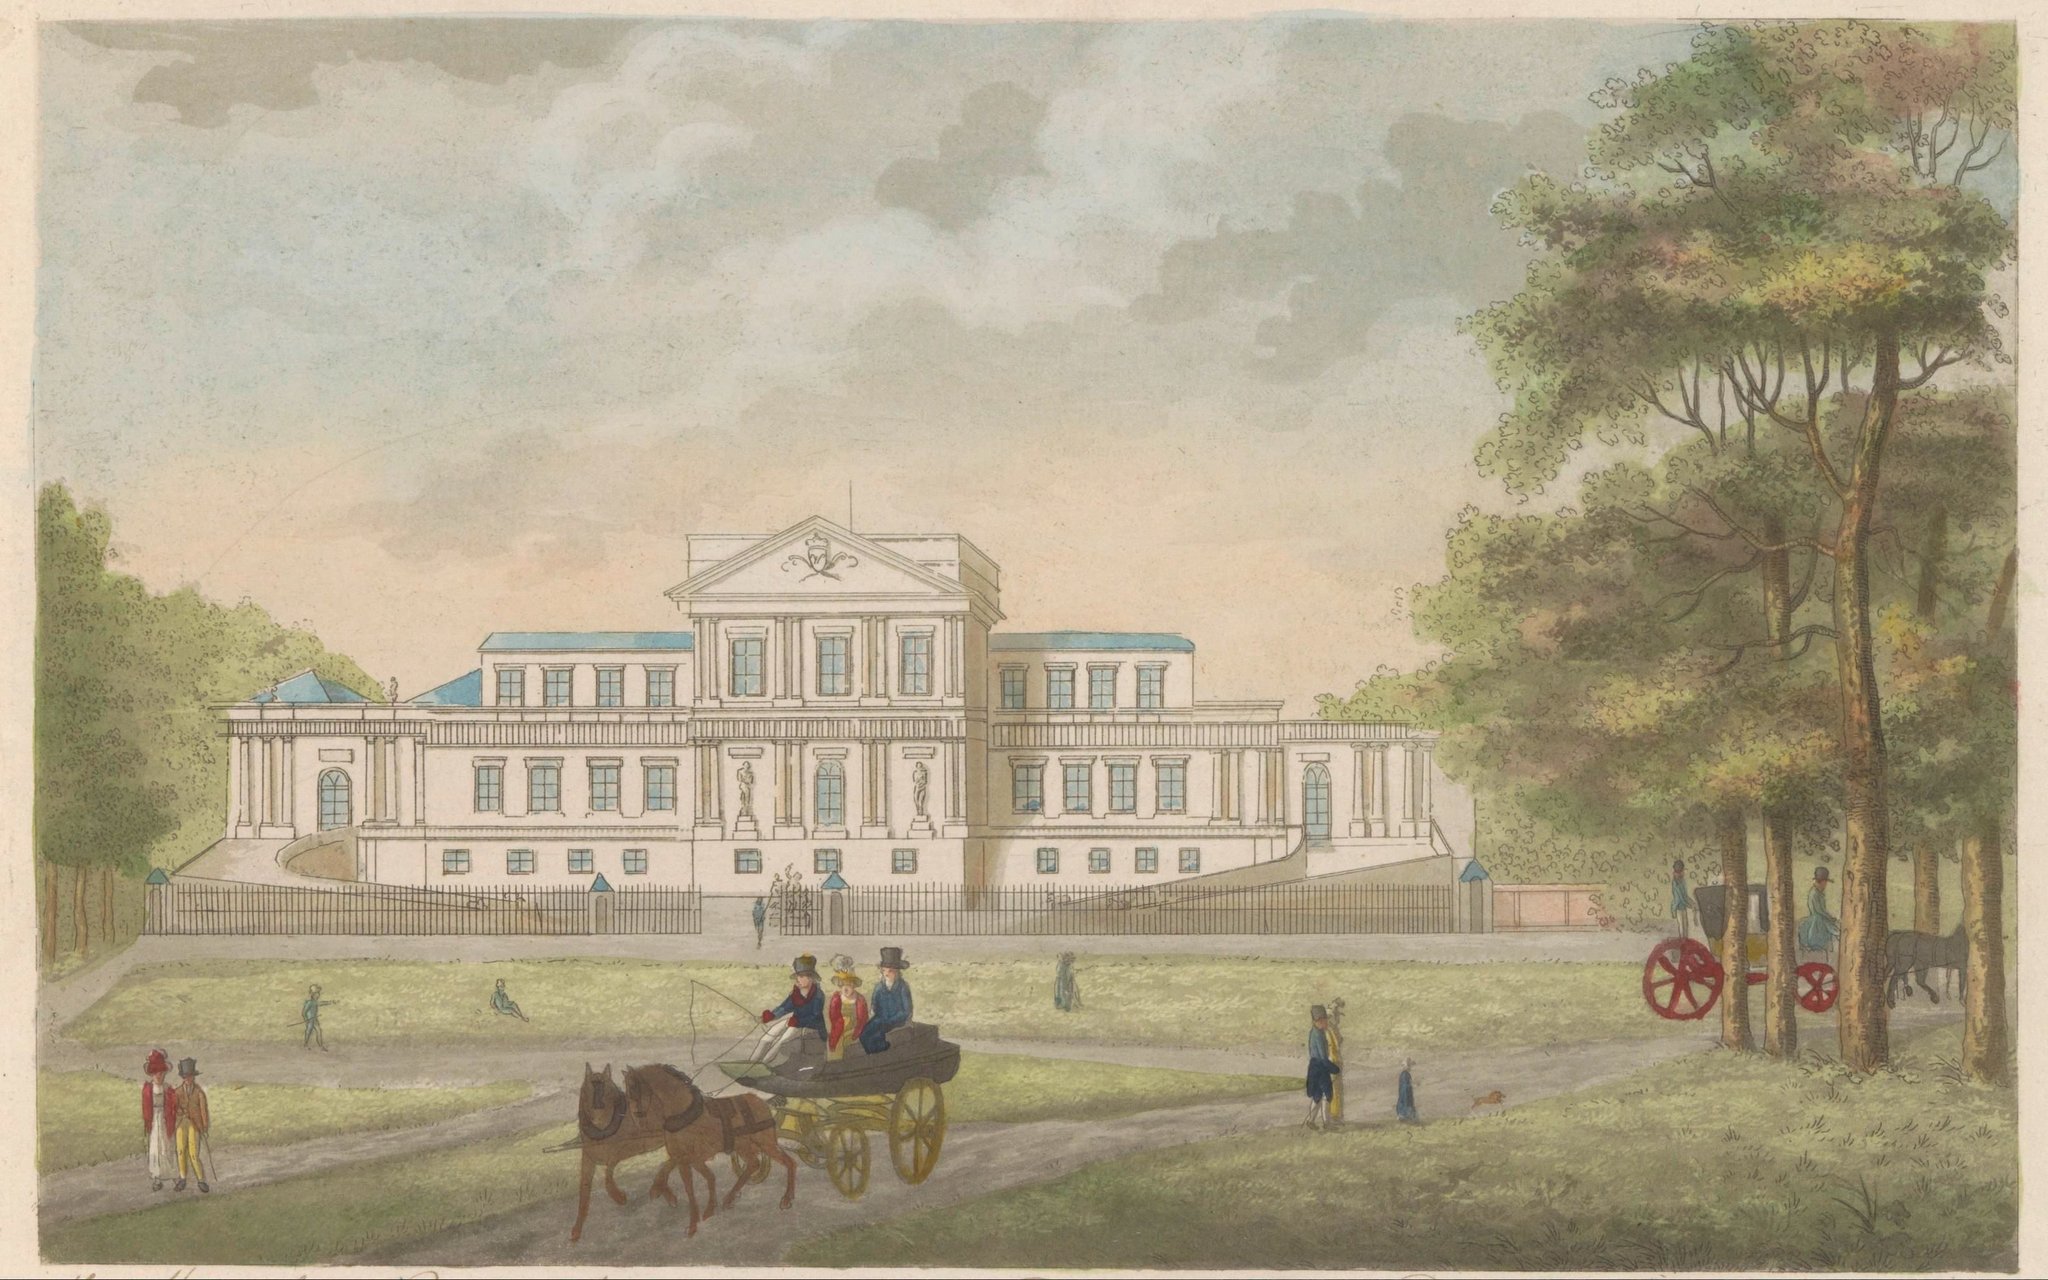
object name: print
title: Het Koninglijke Pavilloen Welgeleegen, gebouwd door den Heere Hope - in den Jaare 1786, bij Haarlem / Le Pavillon Royale Welgeleegen - bati par le Sieur Hope - l'An 1786 - prês de Haarlem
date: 1824-1830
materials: paper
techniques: aquatint, etching, hand coloring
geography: netherlands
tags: haarlem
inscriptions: inscription: ‘Het Koninglijke Pavilloen Welgeleegen, gebouwd door den Heere Hope - in den Jaare 1786, bij Haarlem / Le Pavillon Royale Welgeleegen - bati par le Sieur Hope - l'An 1786 - prês de Haarlem / chez E: Maaskamp à Amsterdam’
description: Gezicht op Paviljoen Welgelegen aan de rand van de Haarlemmerhout te Haarlem, ca. 1825. Gebouwd voor de Amerikaanse bankier Henry Hope in 1789. Onderdeel van een plaatwerk uit ca. 1824-1825 met 74 (ongenummerde) platen van de belangrijkste topografische gezichten en verschillende zeden en gewoonten in het Verenigd Koninkrijk der Nederlanden.